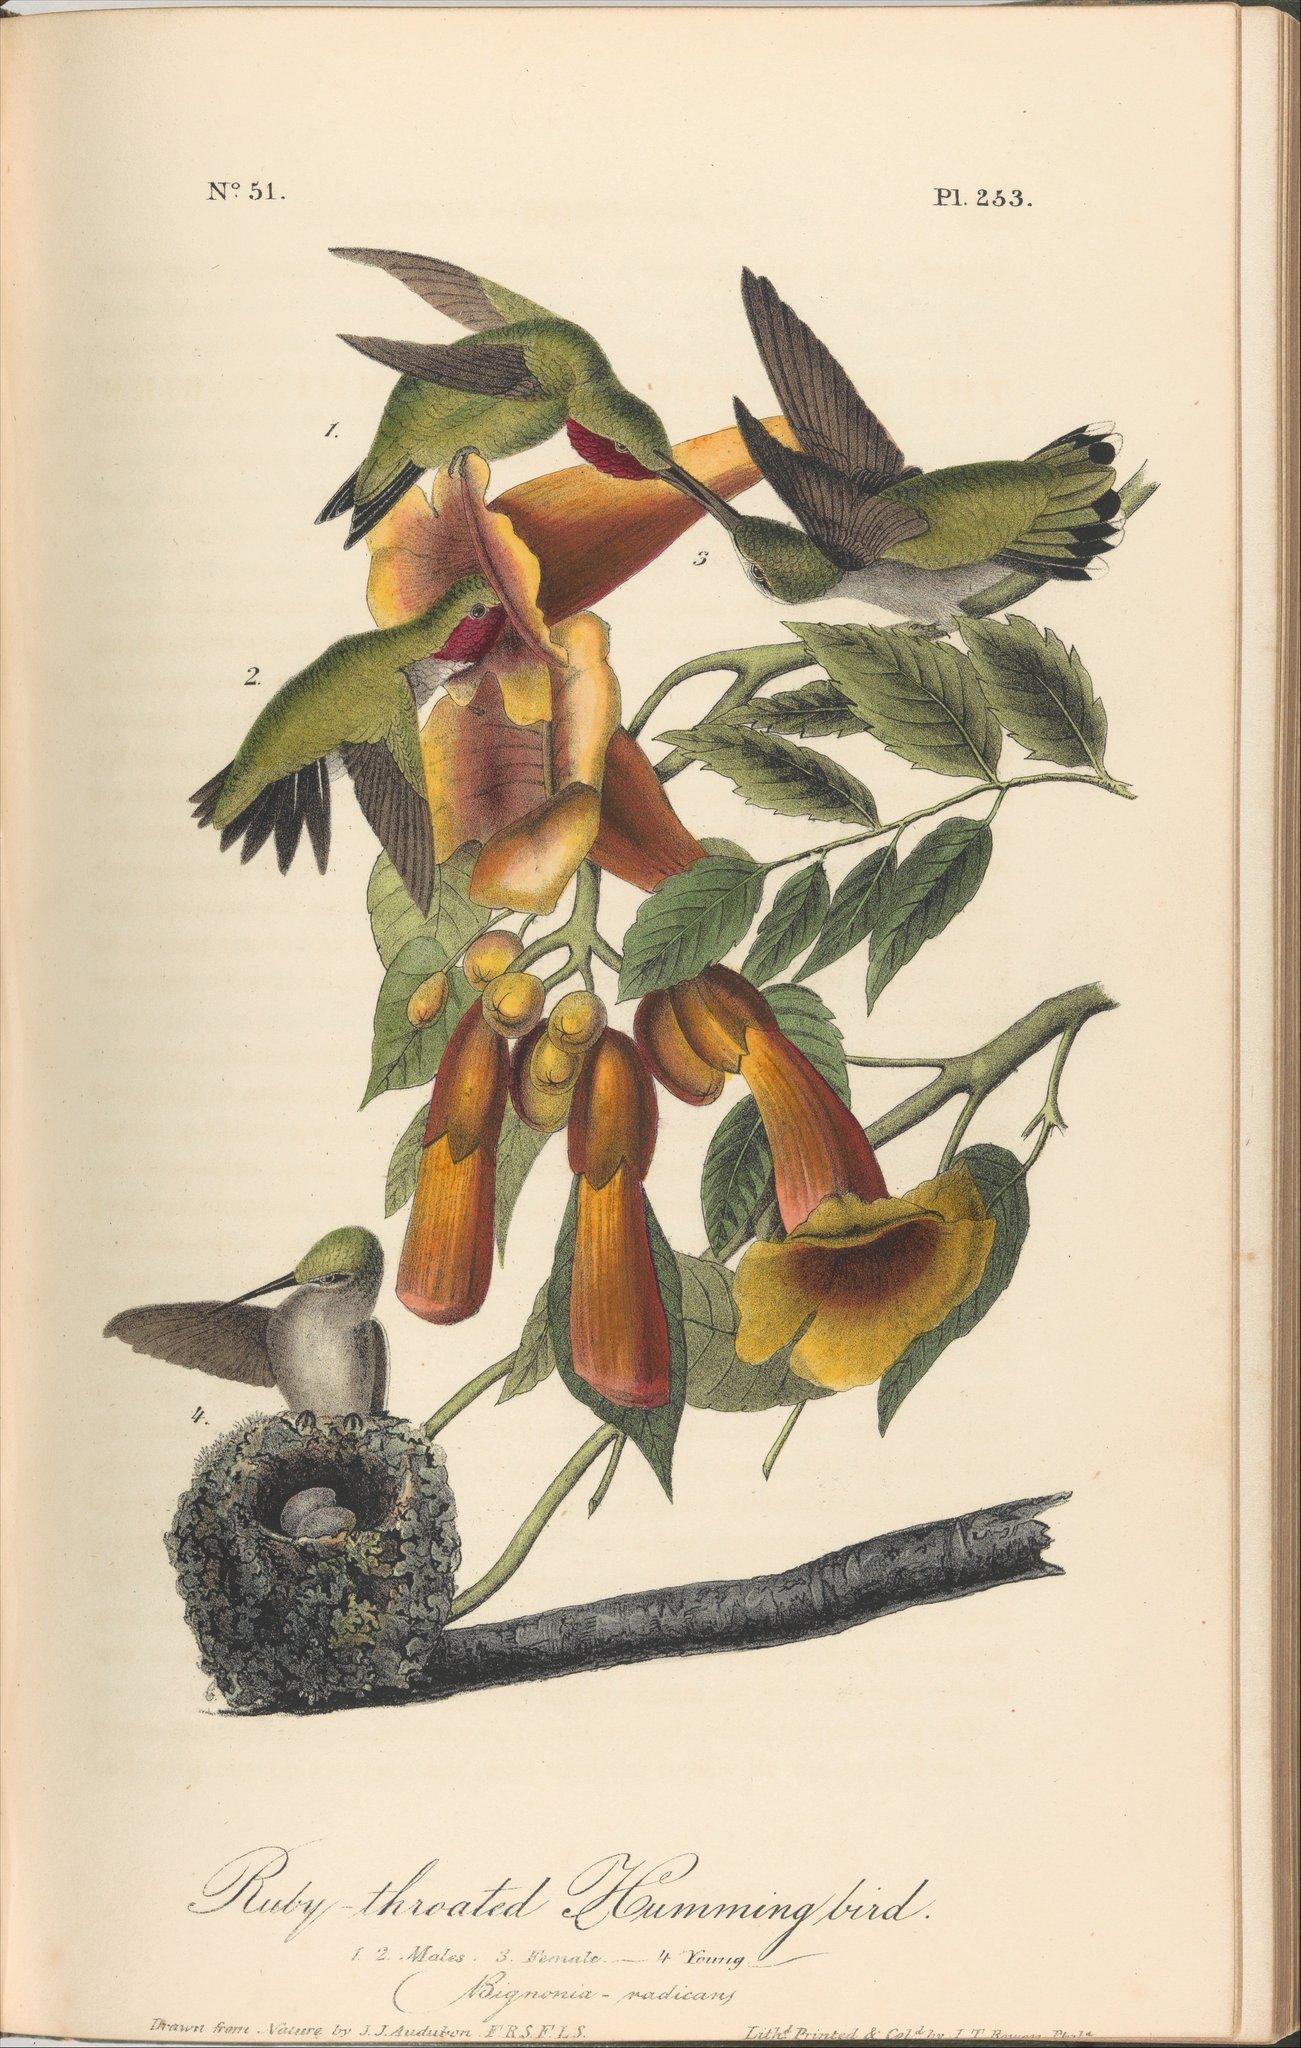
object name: book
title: The Birds of America from Drawings Made in the United States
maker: john james audubon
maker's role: designer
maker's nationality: american, born haiti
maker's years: 1785-1851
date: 1842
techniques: hand coloring, lithograph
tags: birds,leaves,eggs